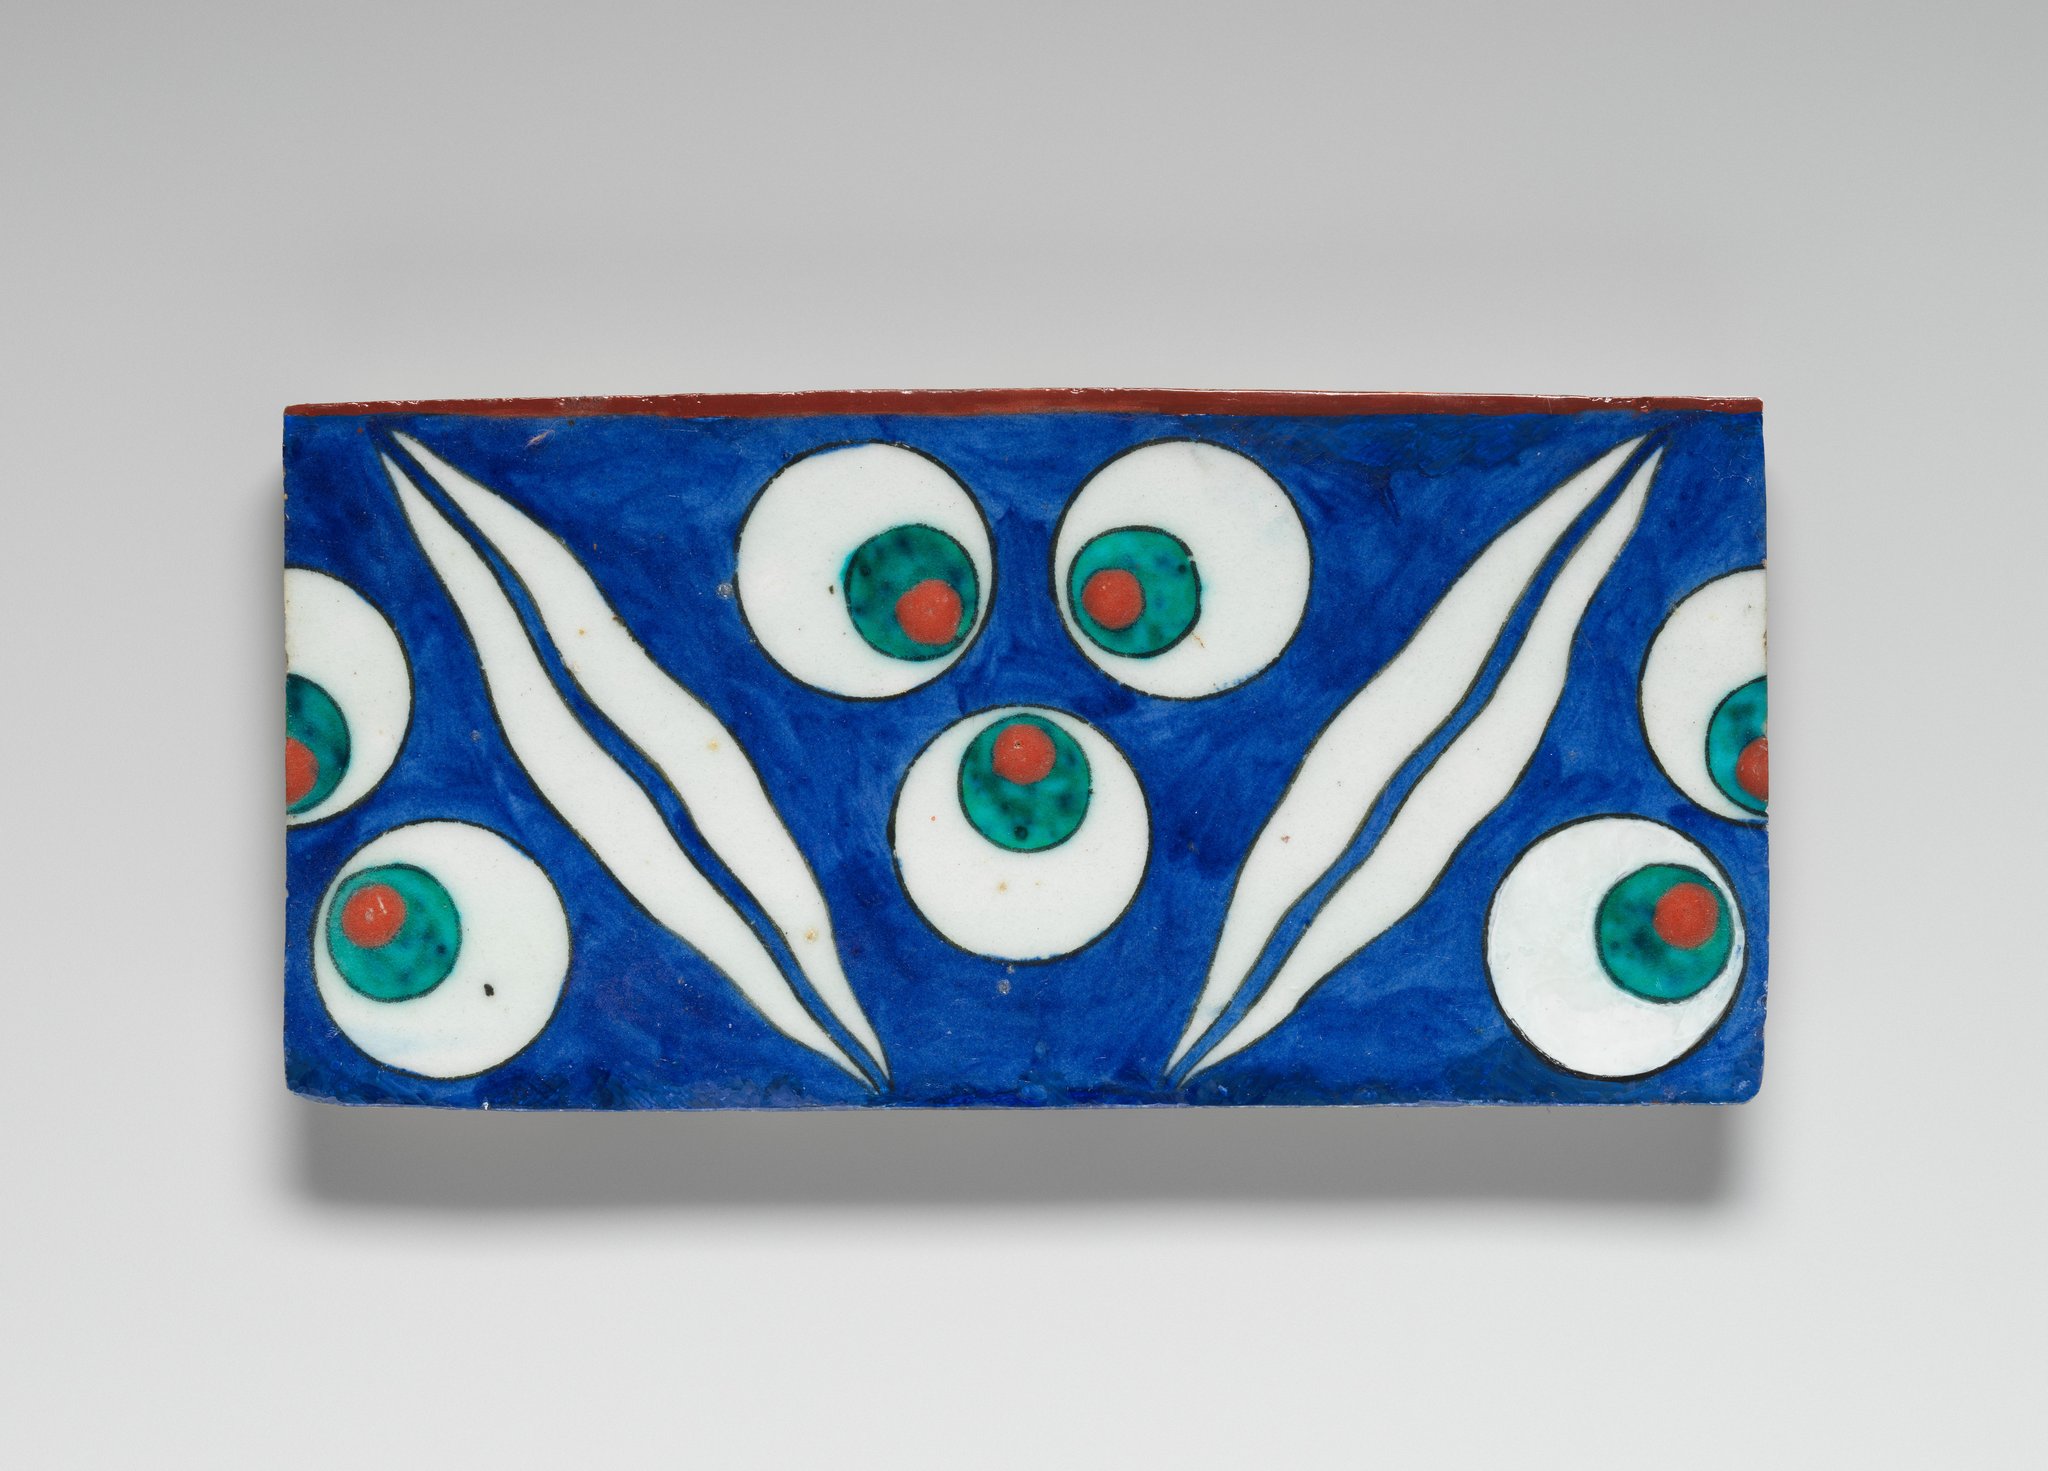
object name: tile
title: Tile with Cintamani Design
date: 1560-1570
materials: glaze, stonepaste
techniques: painting, polychrome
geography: turkey